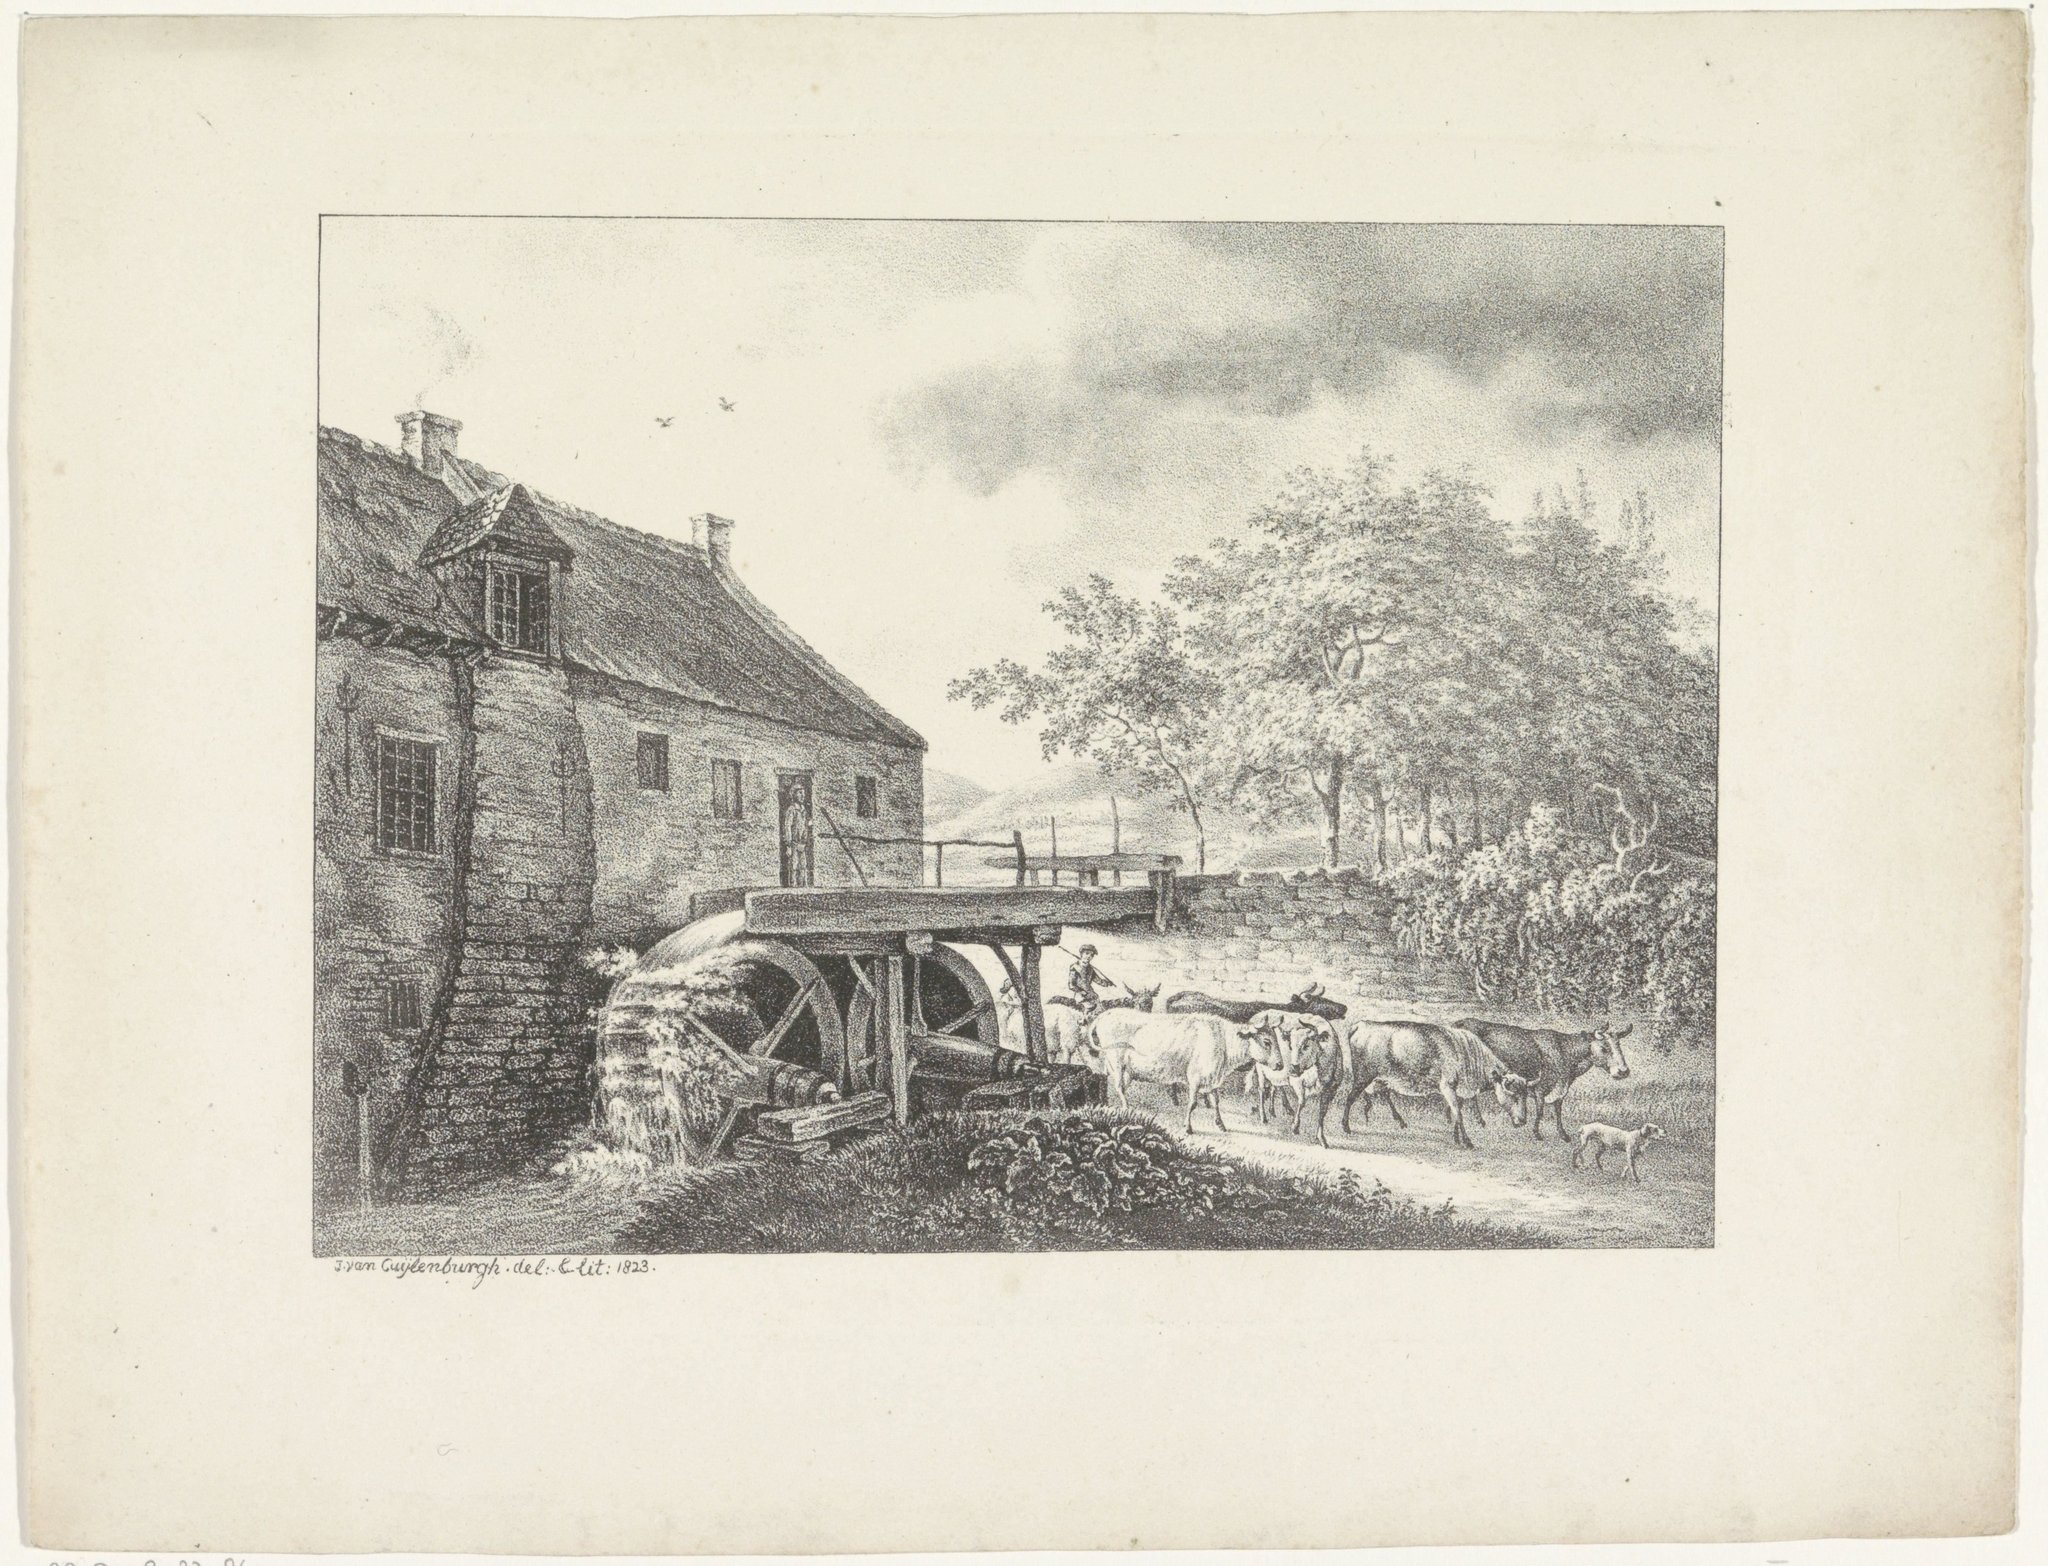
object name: print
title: Landschap met watermolen en koeien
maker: johannes van cuylenburgh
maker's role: print maker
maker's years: 1793-1841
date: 1823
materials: paper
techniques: lithograph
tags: herding, herdsman, herdswoman, shepherd, shepherdess, cowherd, etc., watermill in landscape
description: De koeien worden door een jongen vooruit gedreven langs de watermolen. Een hond loopt voorop. Water stroomt door de molen.